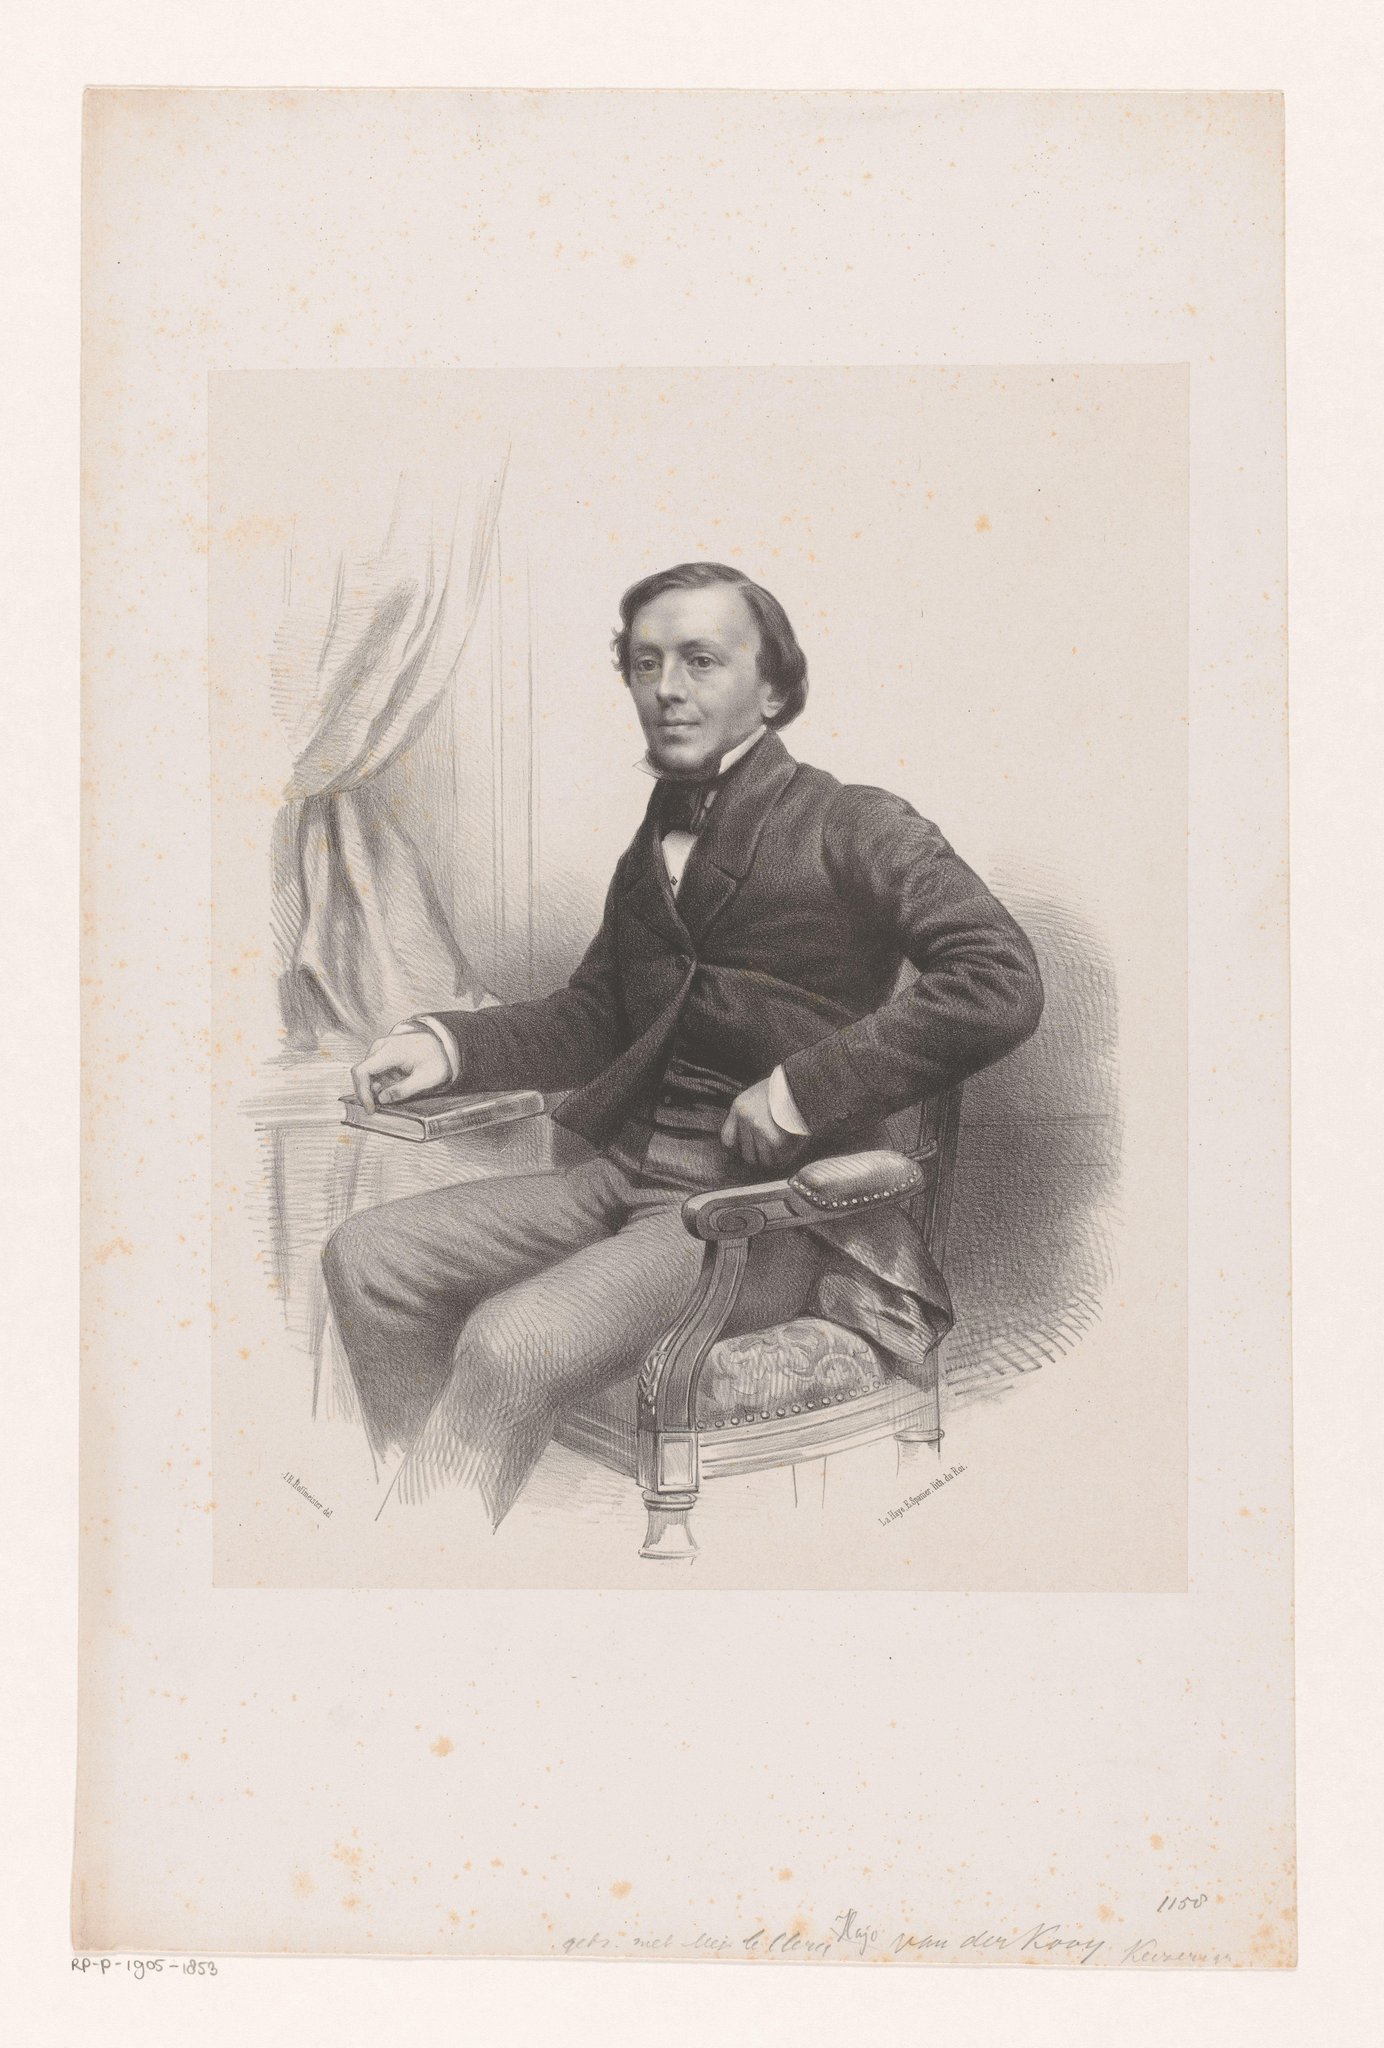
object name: print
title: Portret van Hayo van der Kooi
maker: johan hendrik hoffmeister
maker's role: print maker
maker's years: 1823-1904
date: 1851-1883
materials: paper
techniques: lithograph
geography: the hague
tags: historical persons (+ three-quarter length portrait)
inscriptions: collector's mark: Lugt 2228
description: De geportretteerde zit aan tafel met zijn linkerhand in zijn vestzak.